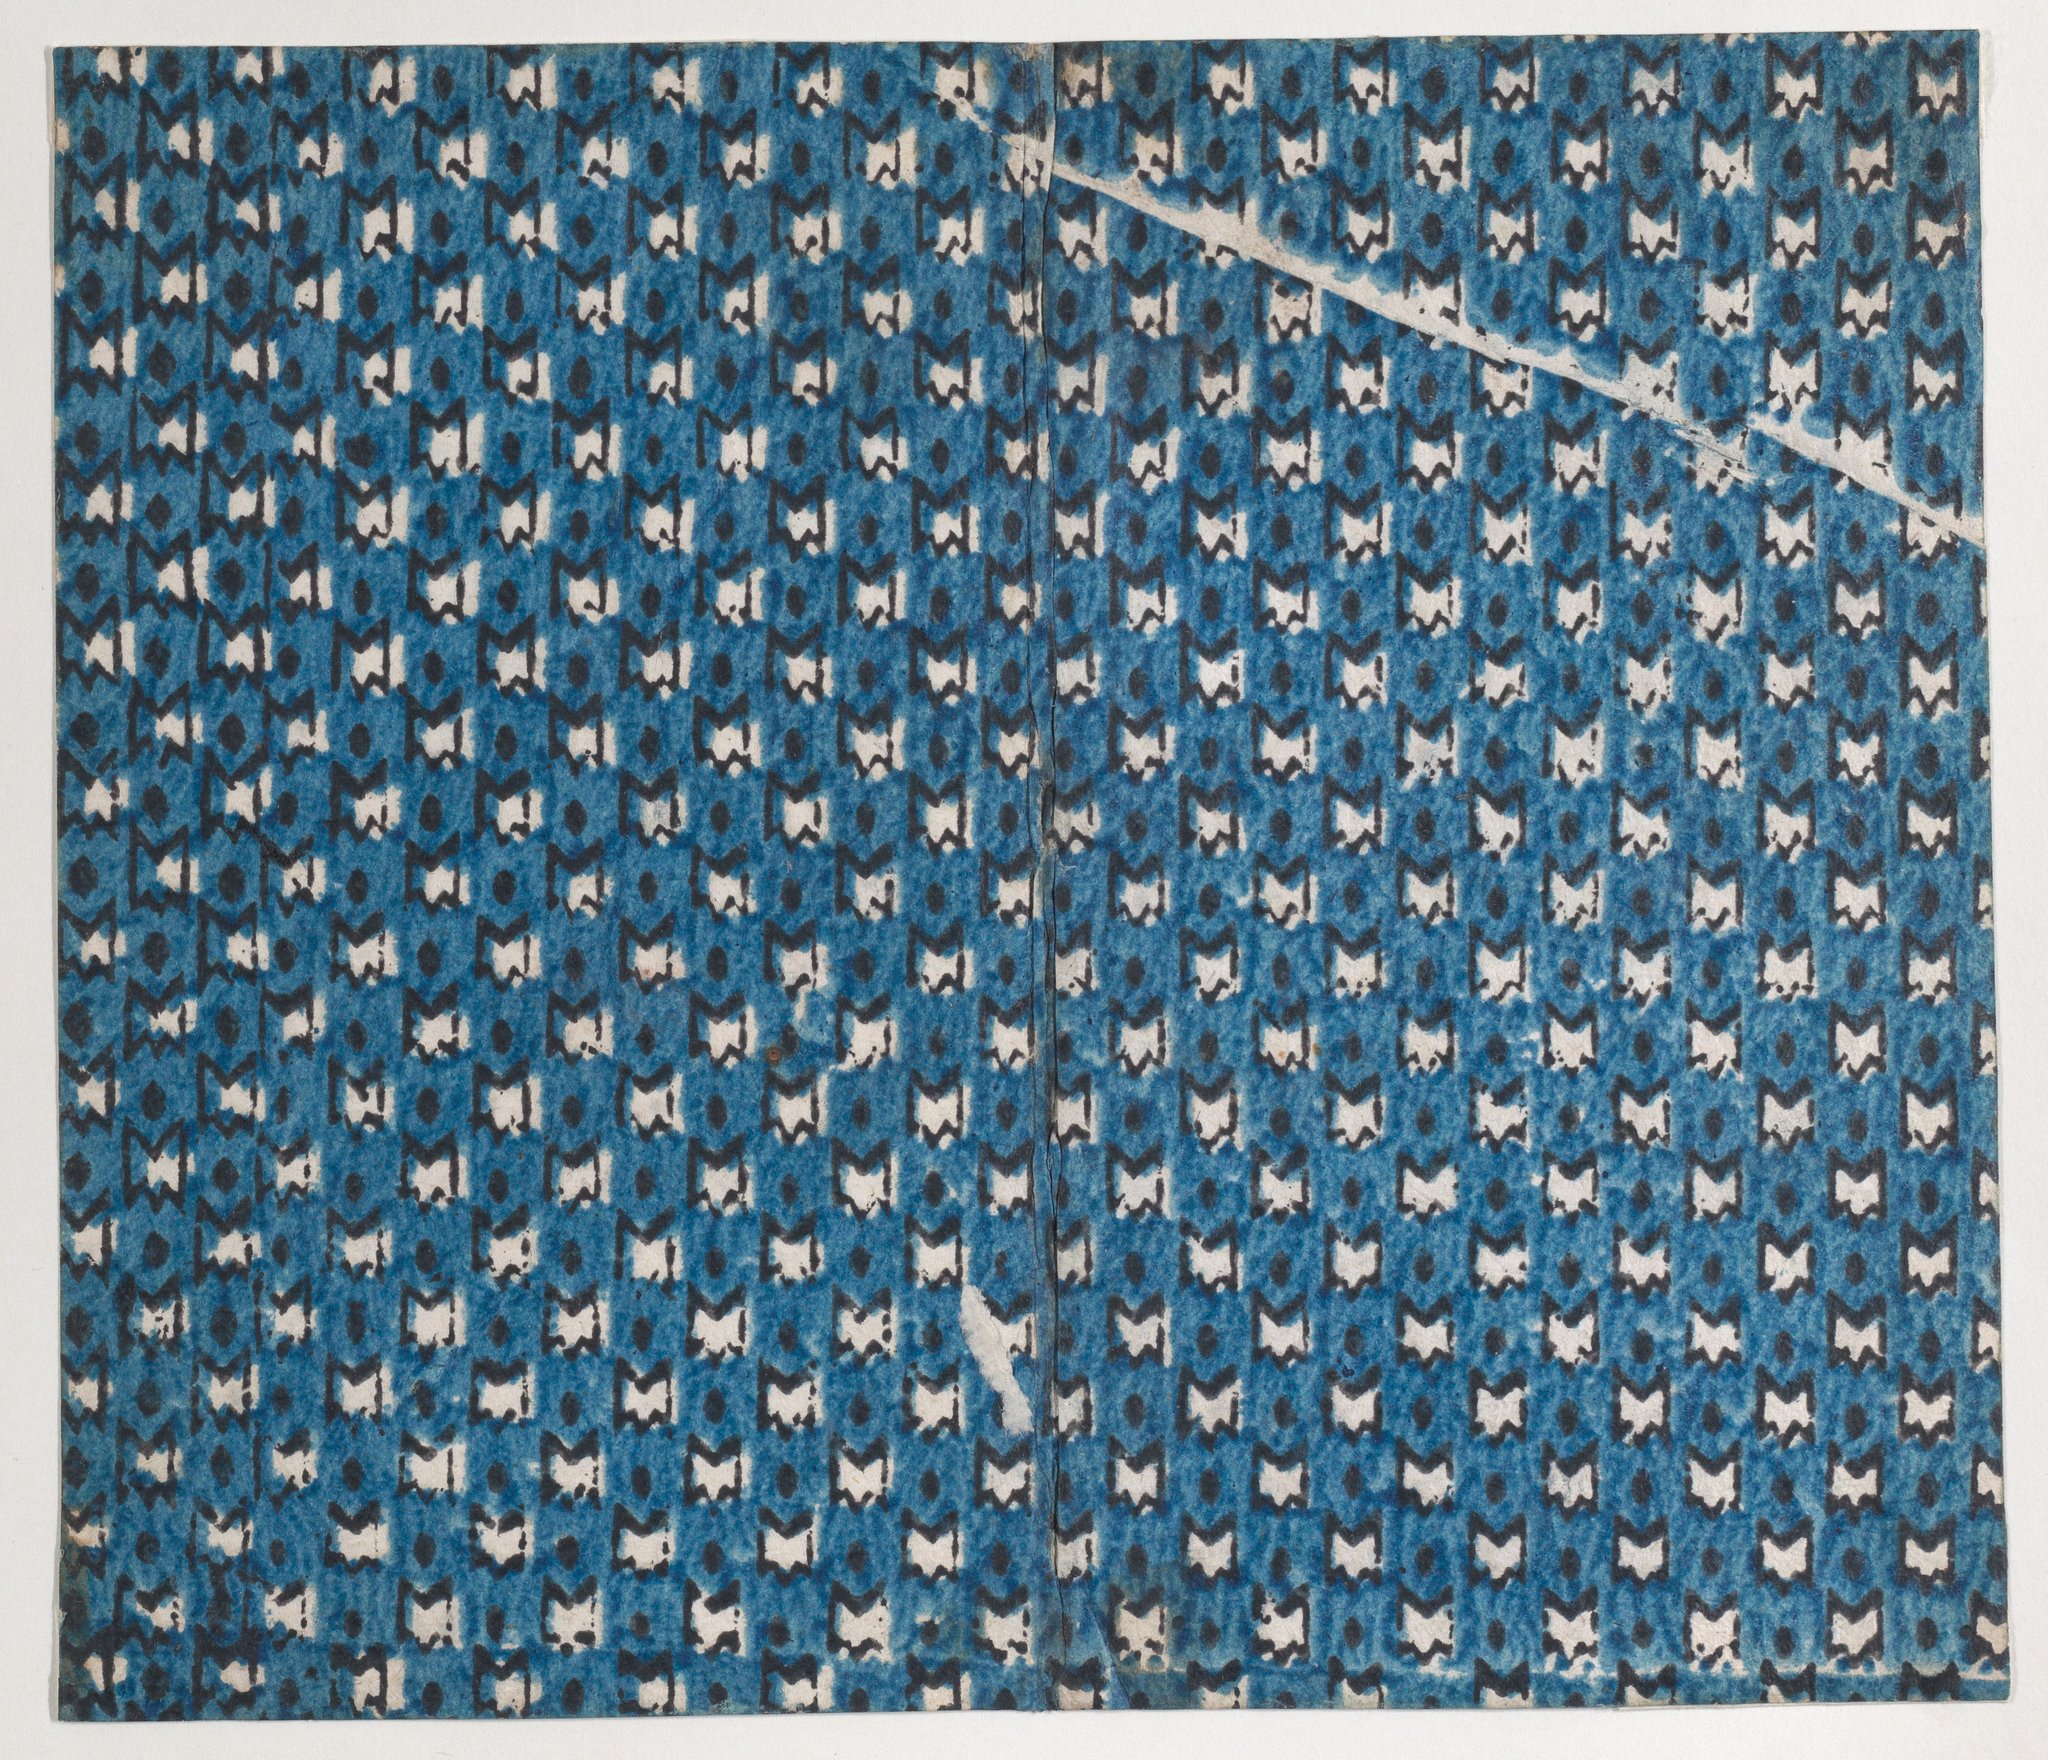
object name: print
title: Book cover with overall pattern of stars within ovals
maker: Anonymous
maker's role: artist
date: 1801-1900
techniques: relief print